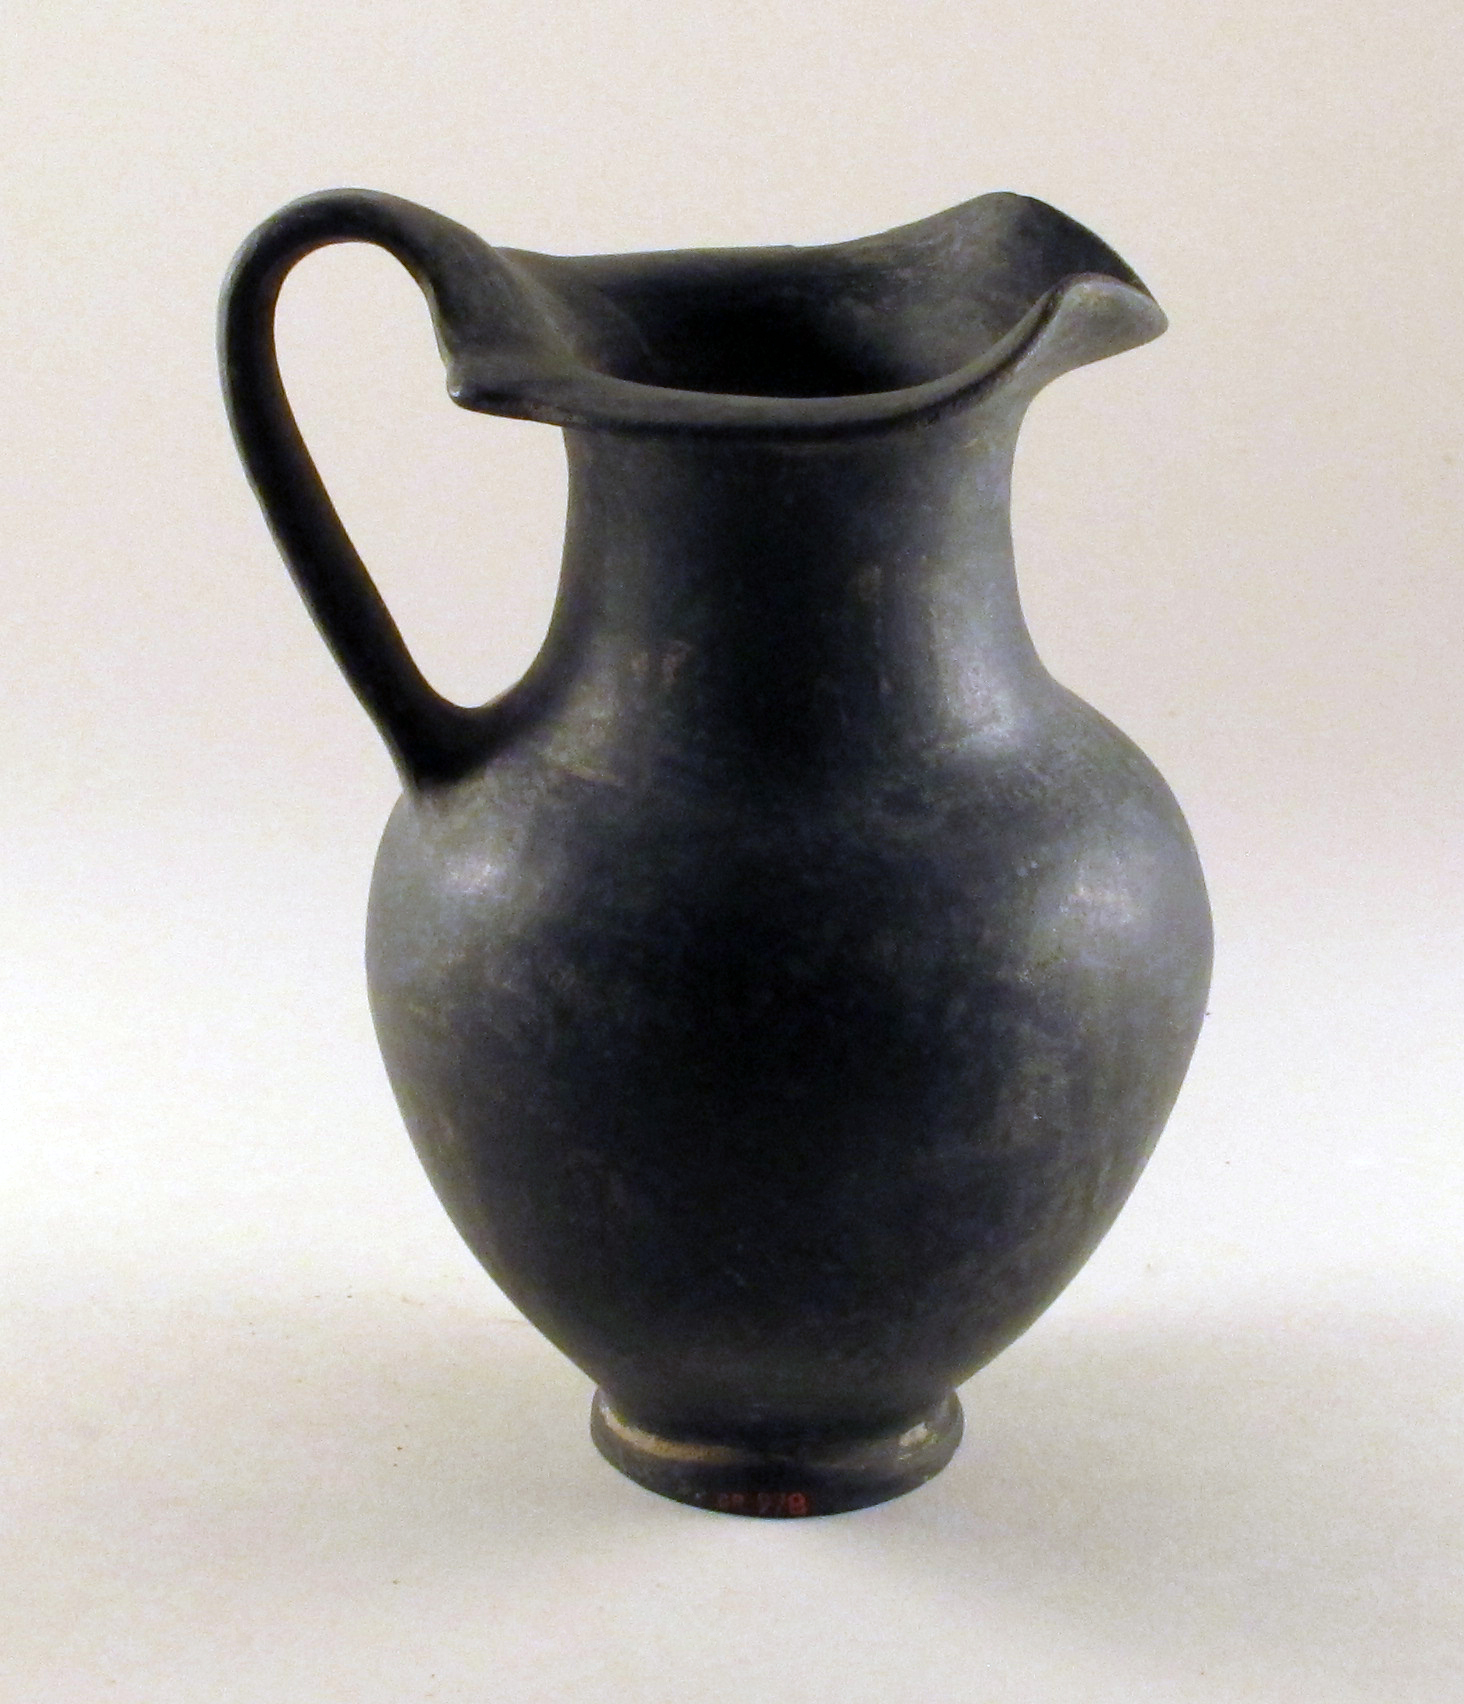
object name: jug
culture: etruscan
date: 590-540 BCE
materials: terracotta